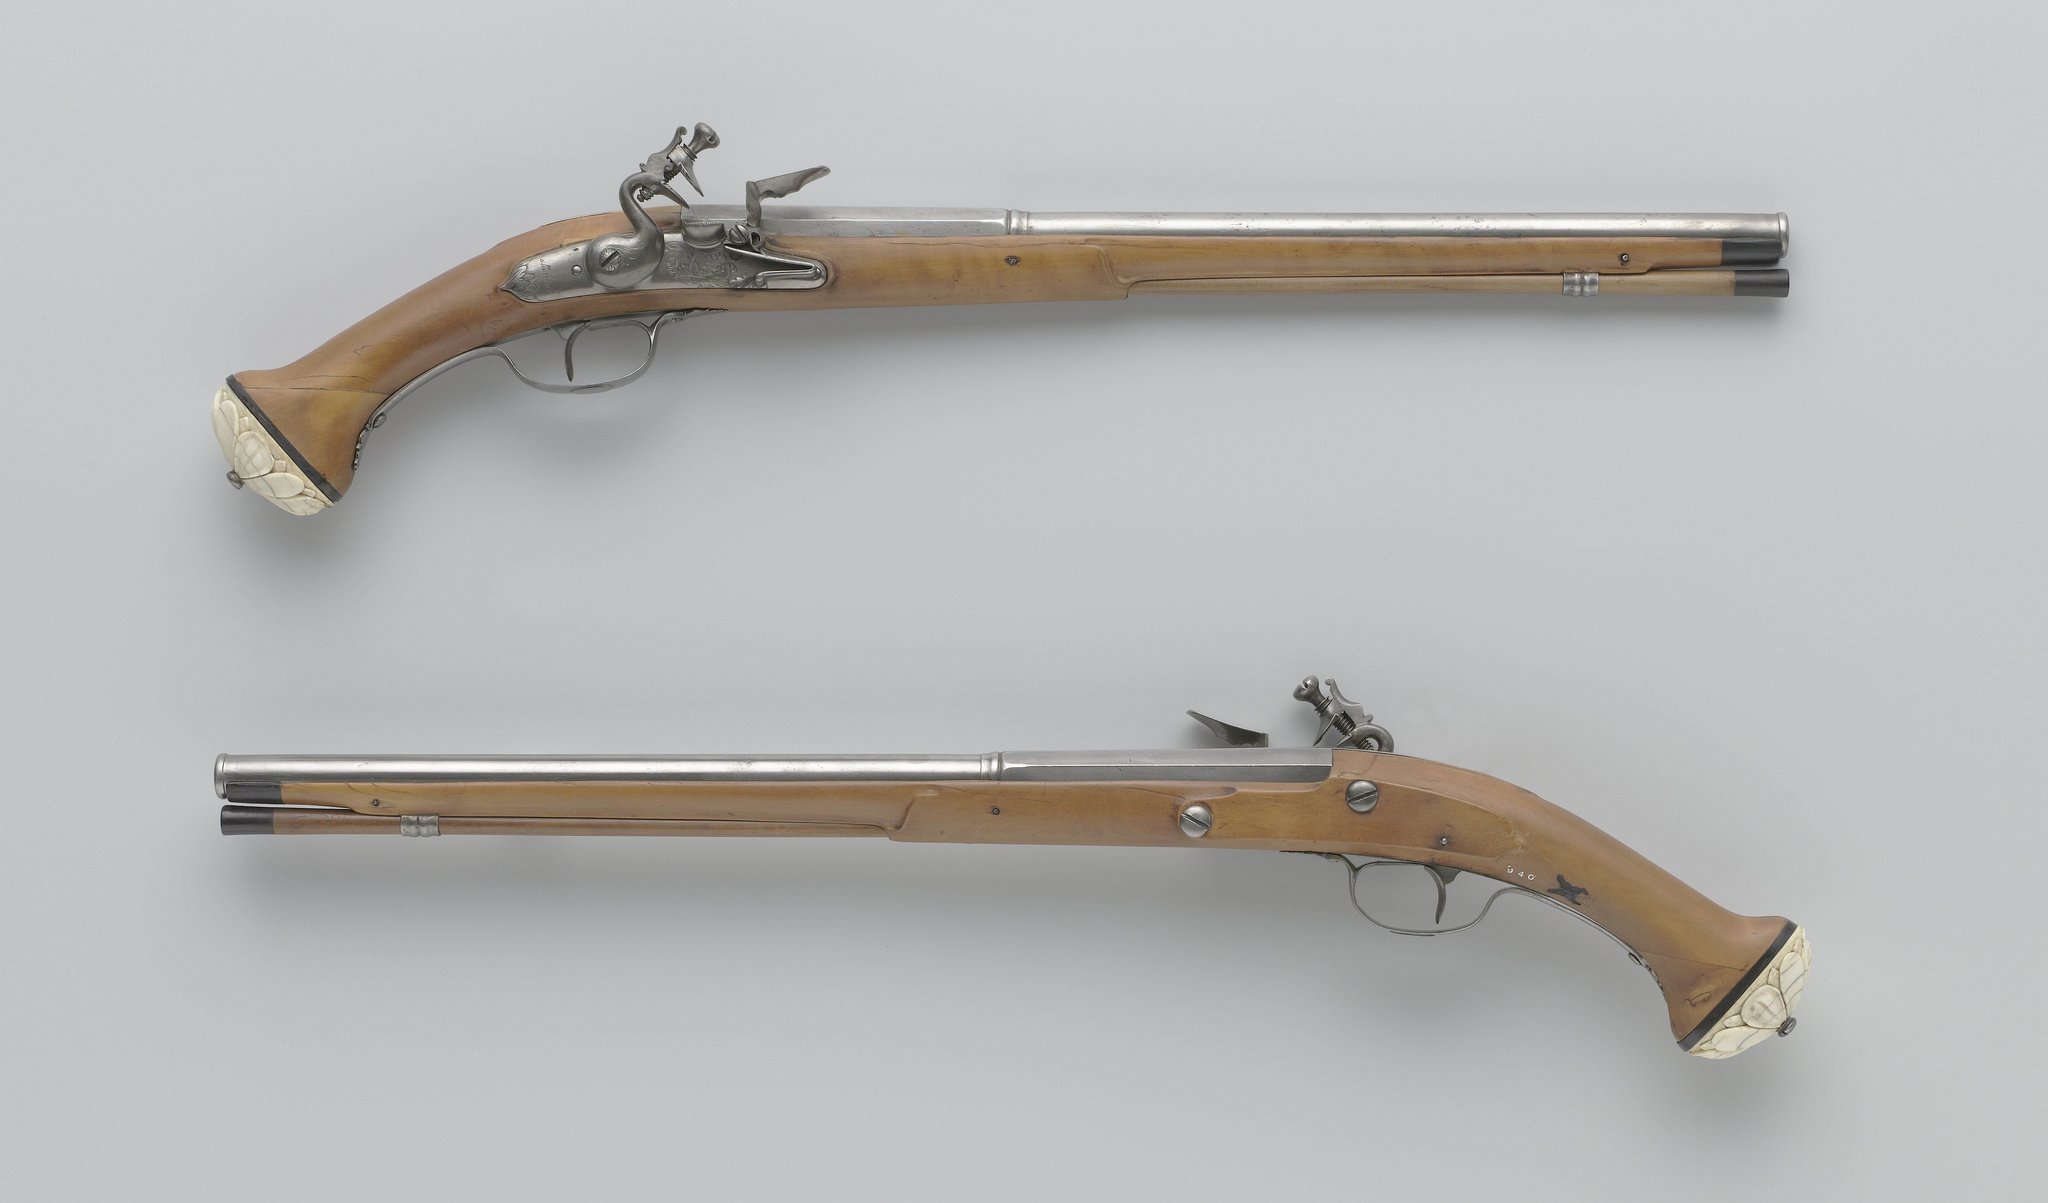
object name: flintlock pistol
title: Vuursteenpistool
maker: Anonymous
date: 1660-1665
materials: wood, horn, iron, ivory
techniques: printing, cutting, engraving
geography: maastricht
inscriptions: initials: ‘MIM ([C:?]MIM); IR’, mark: ‘13; 14’